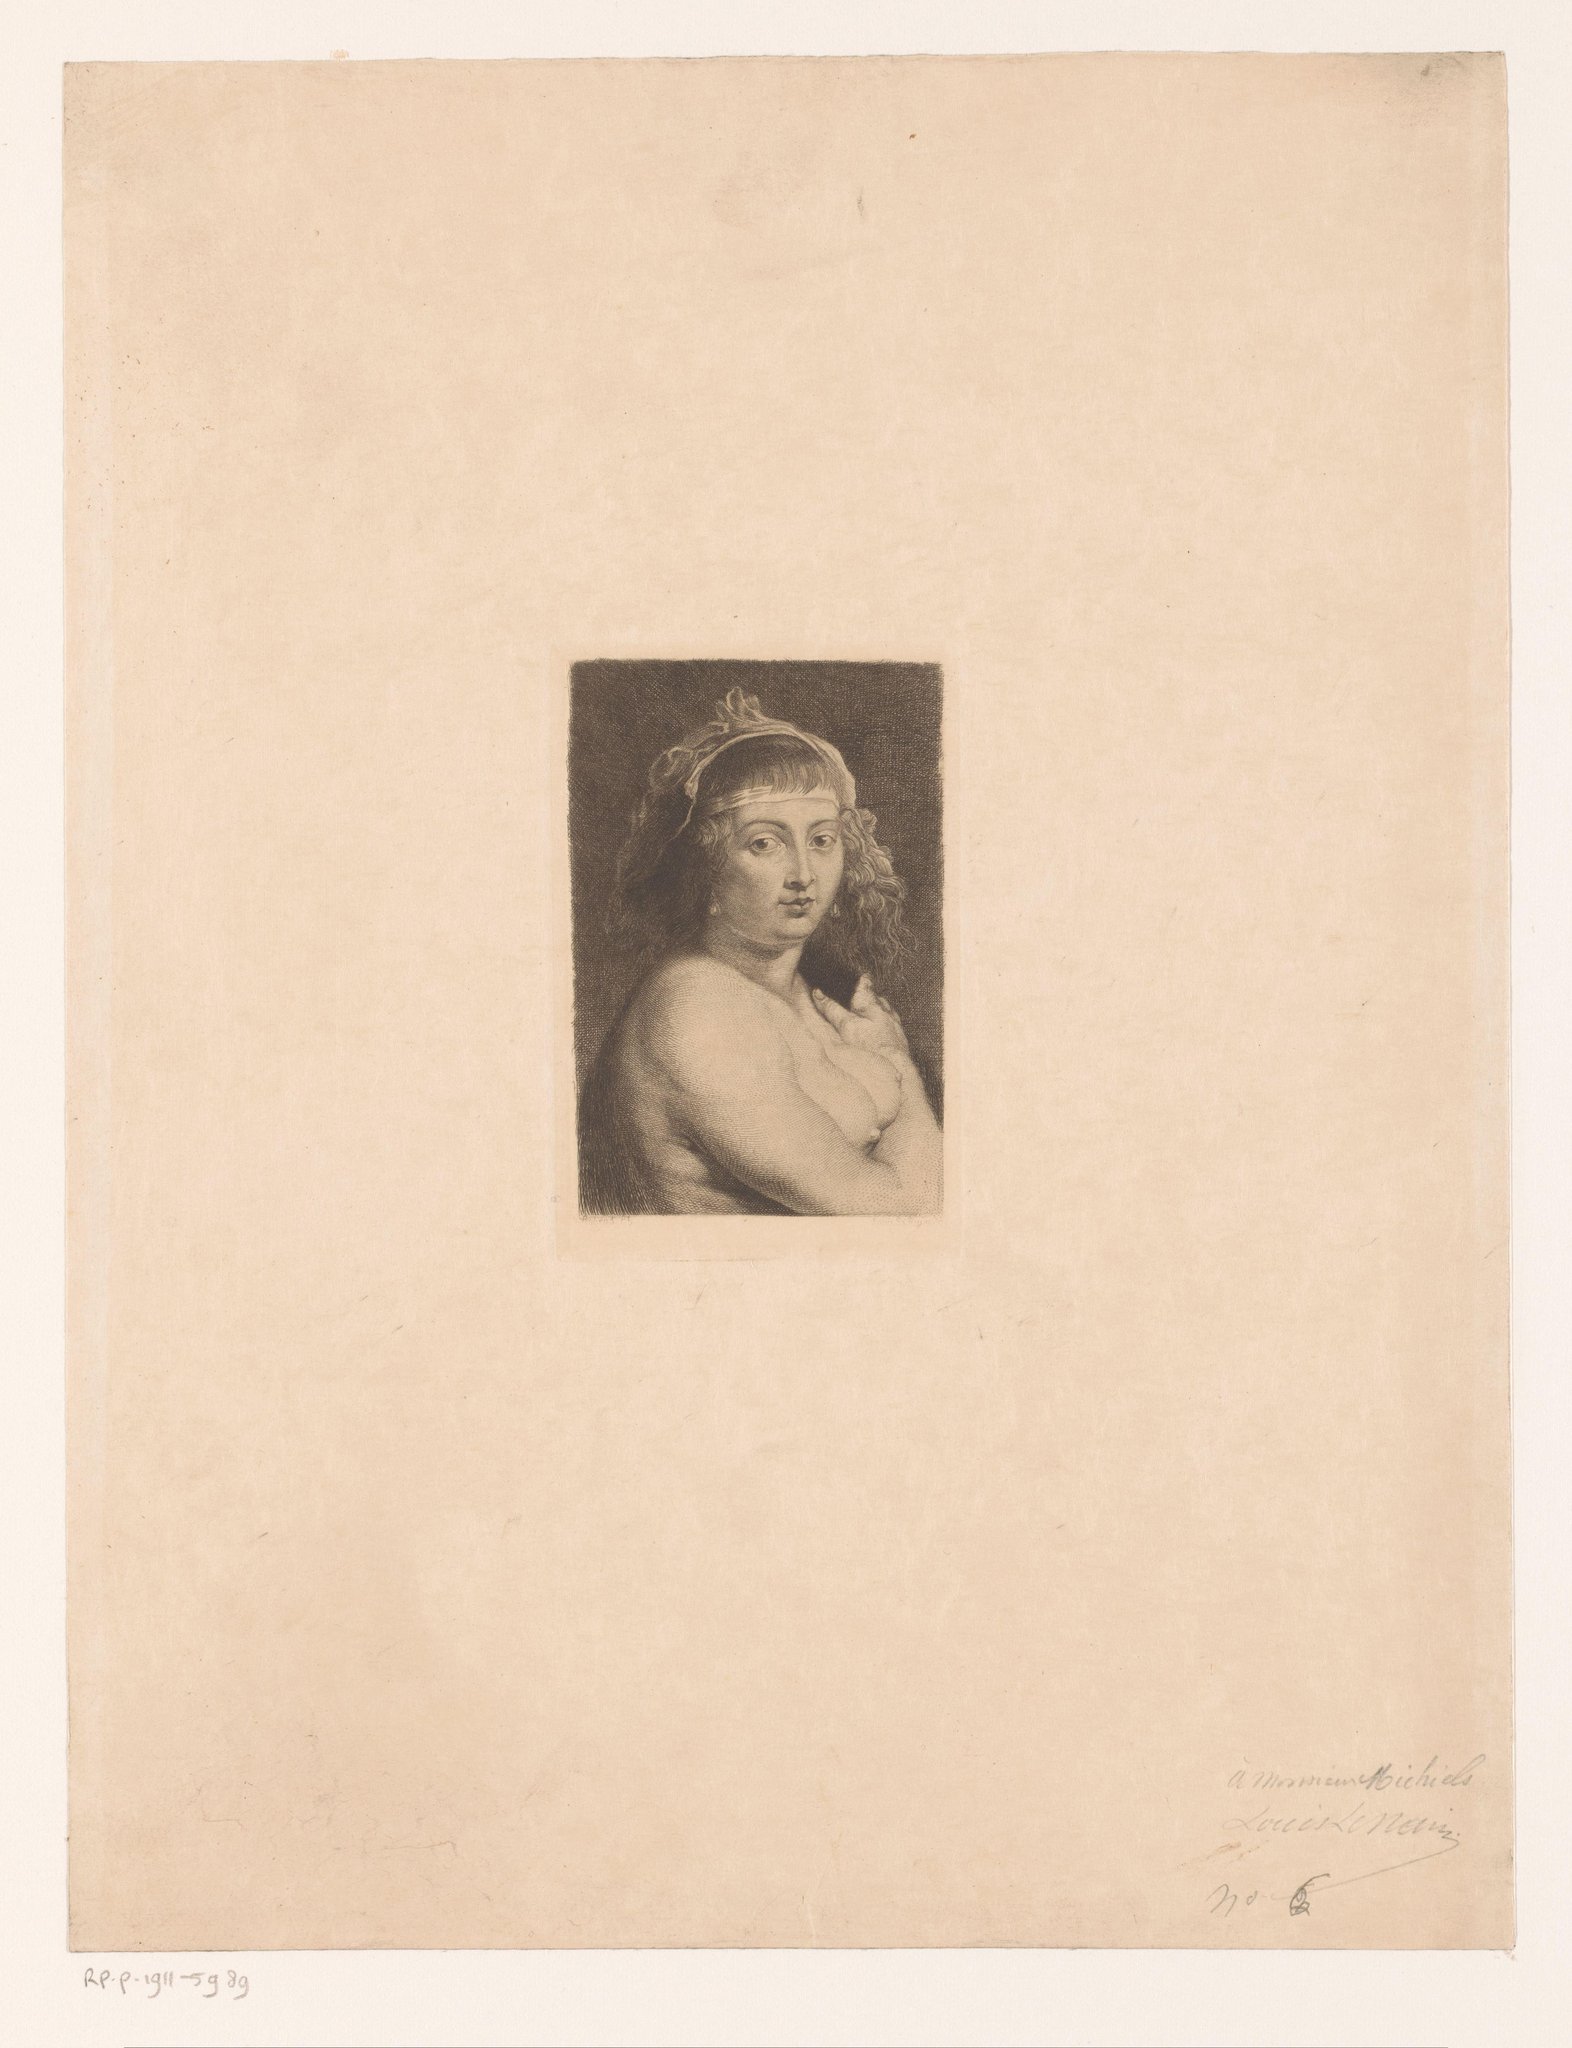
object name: print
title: Portret van Helena Fourment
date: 1861-1911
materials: paper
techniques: etching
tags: historical persons, breasts - aa - female human figure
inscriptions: collector's mark: Lugt 2228, inscription: ‘à Monsieur Michiels, Louis Le Nain no 6’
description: Detail van een schilderij van Peter Paul Rubens. Helena Fourment was de nicht en tweede vrouw van Rubens.